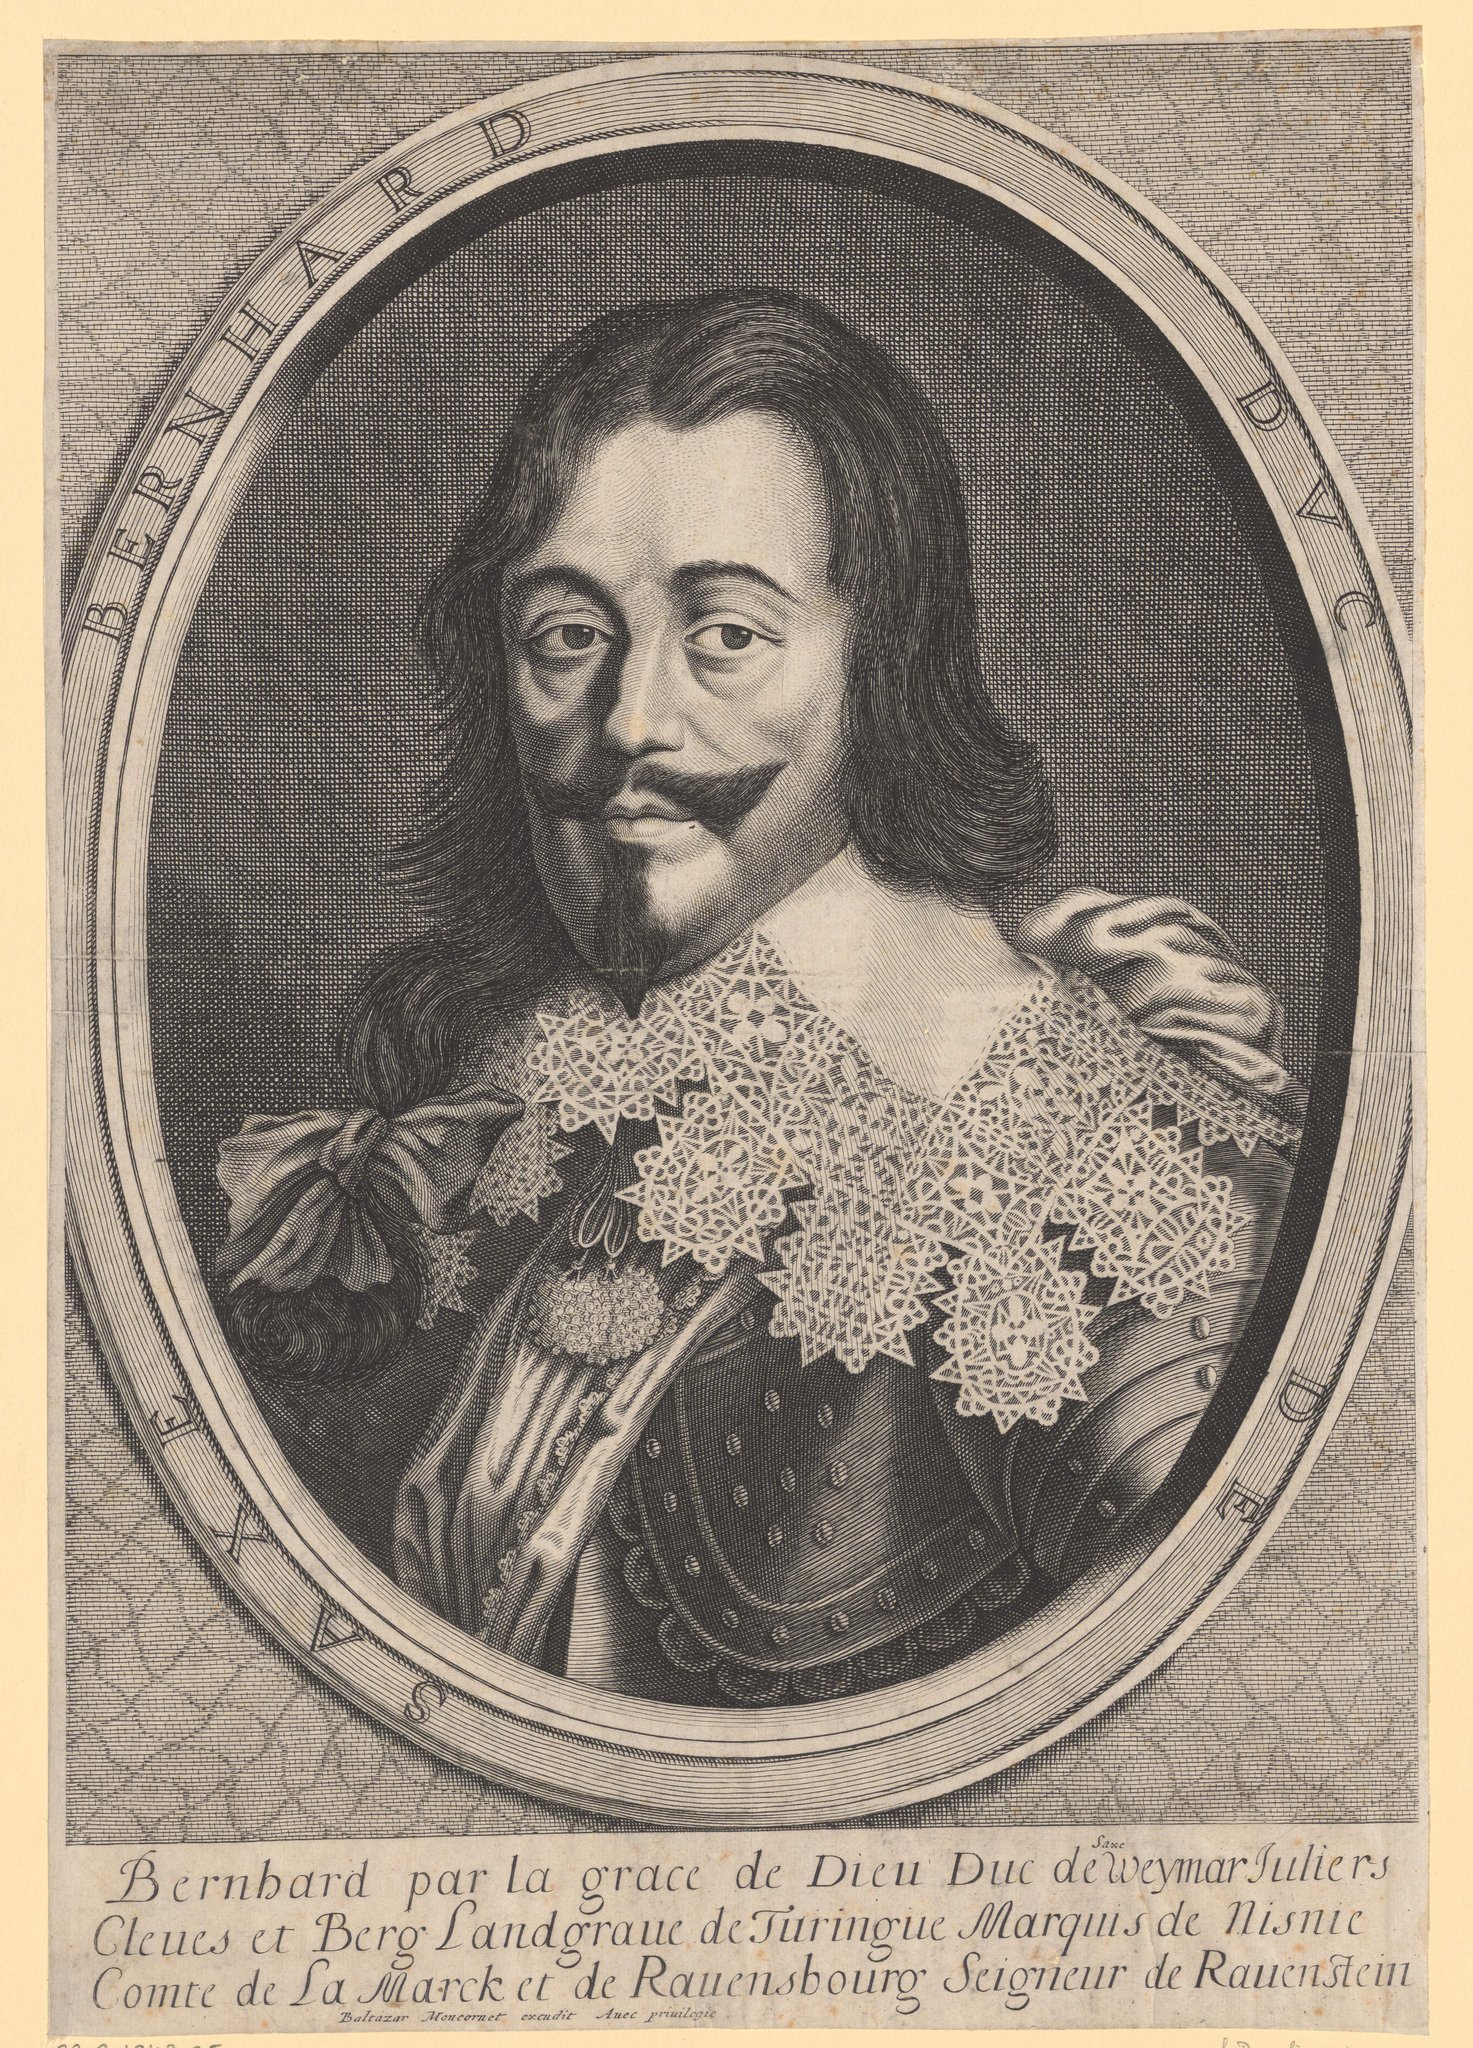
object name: print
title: Portret van Bernhard, hertog van Saksen-Weimar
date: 1630-1668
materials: paper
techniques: engraving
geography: paris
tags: armour, historical persons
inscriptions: collector's mark: Lugt 2228